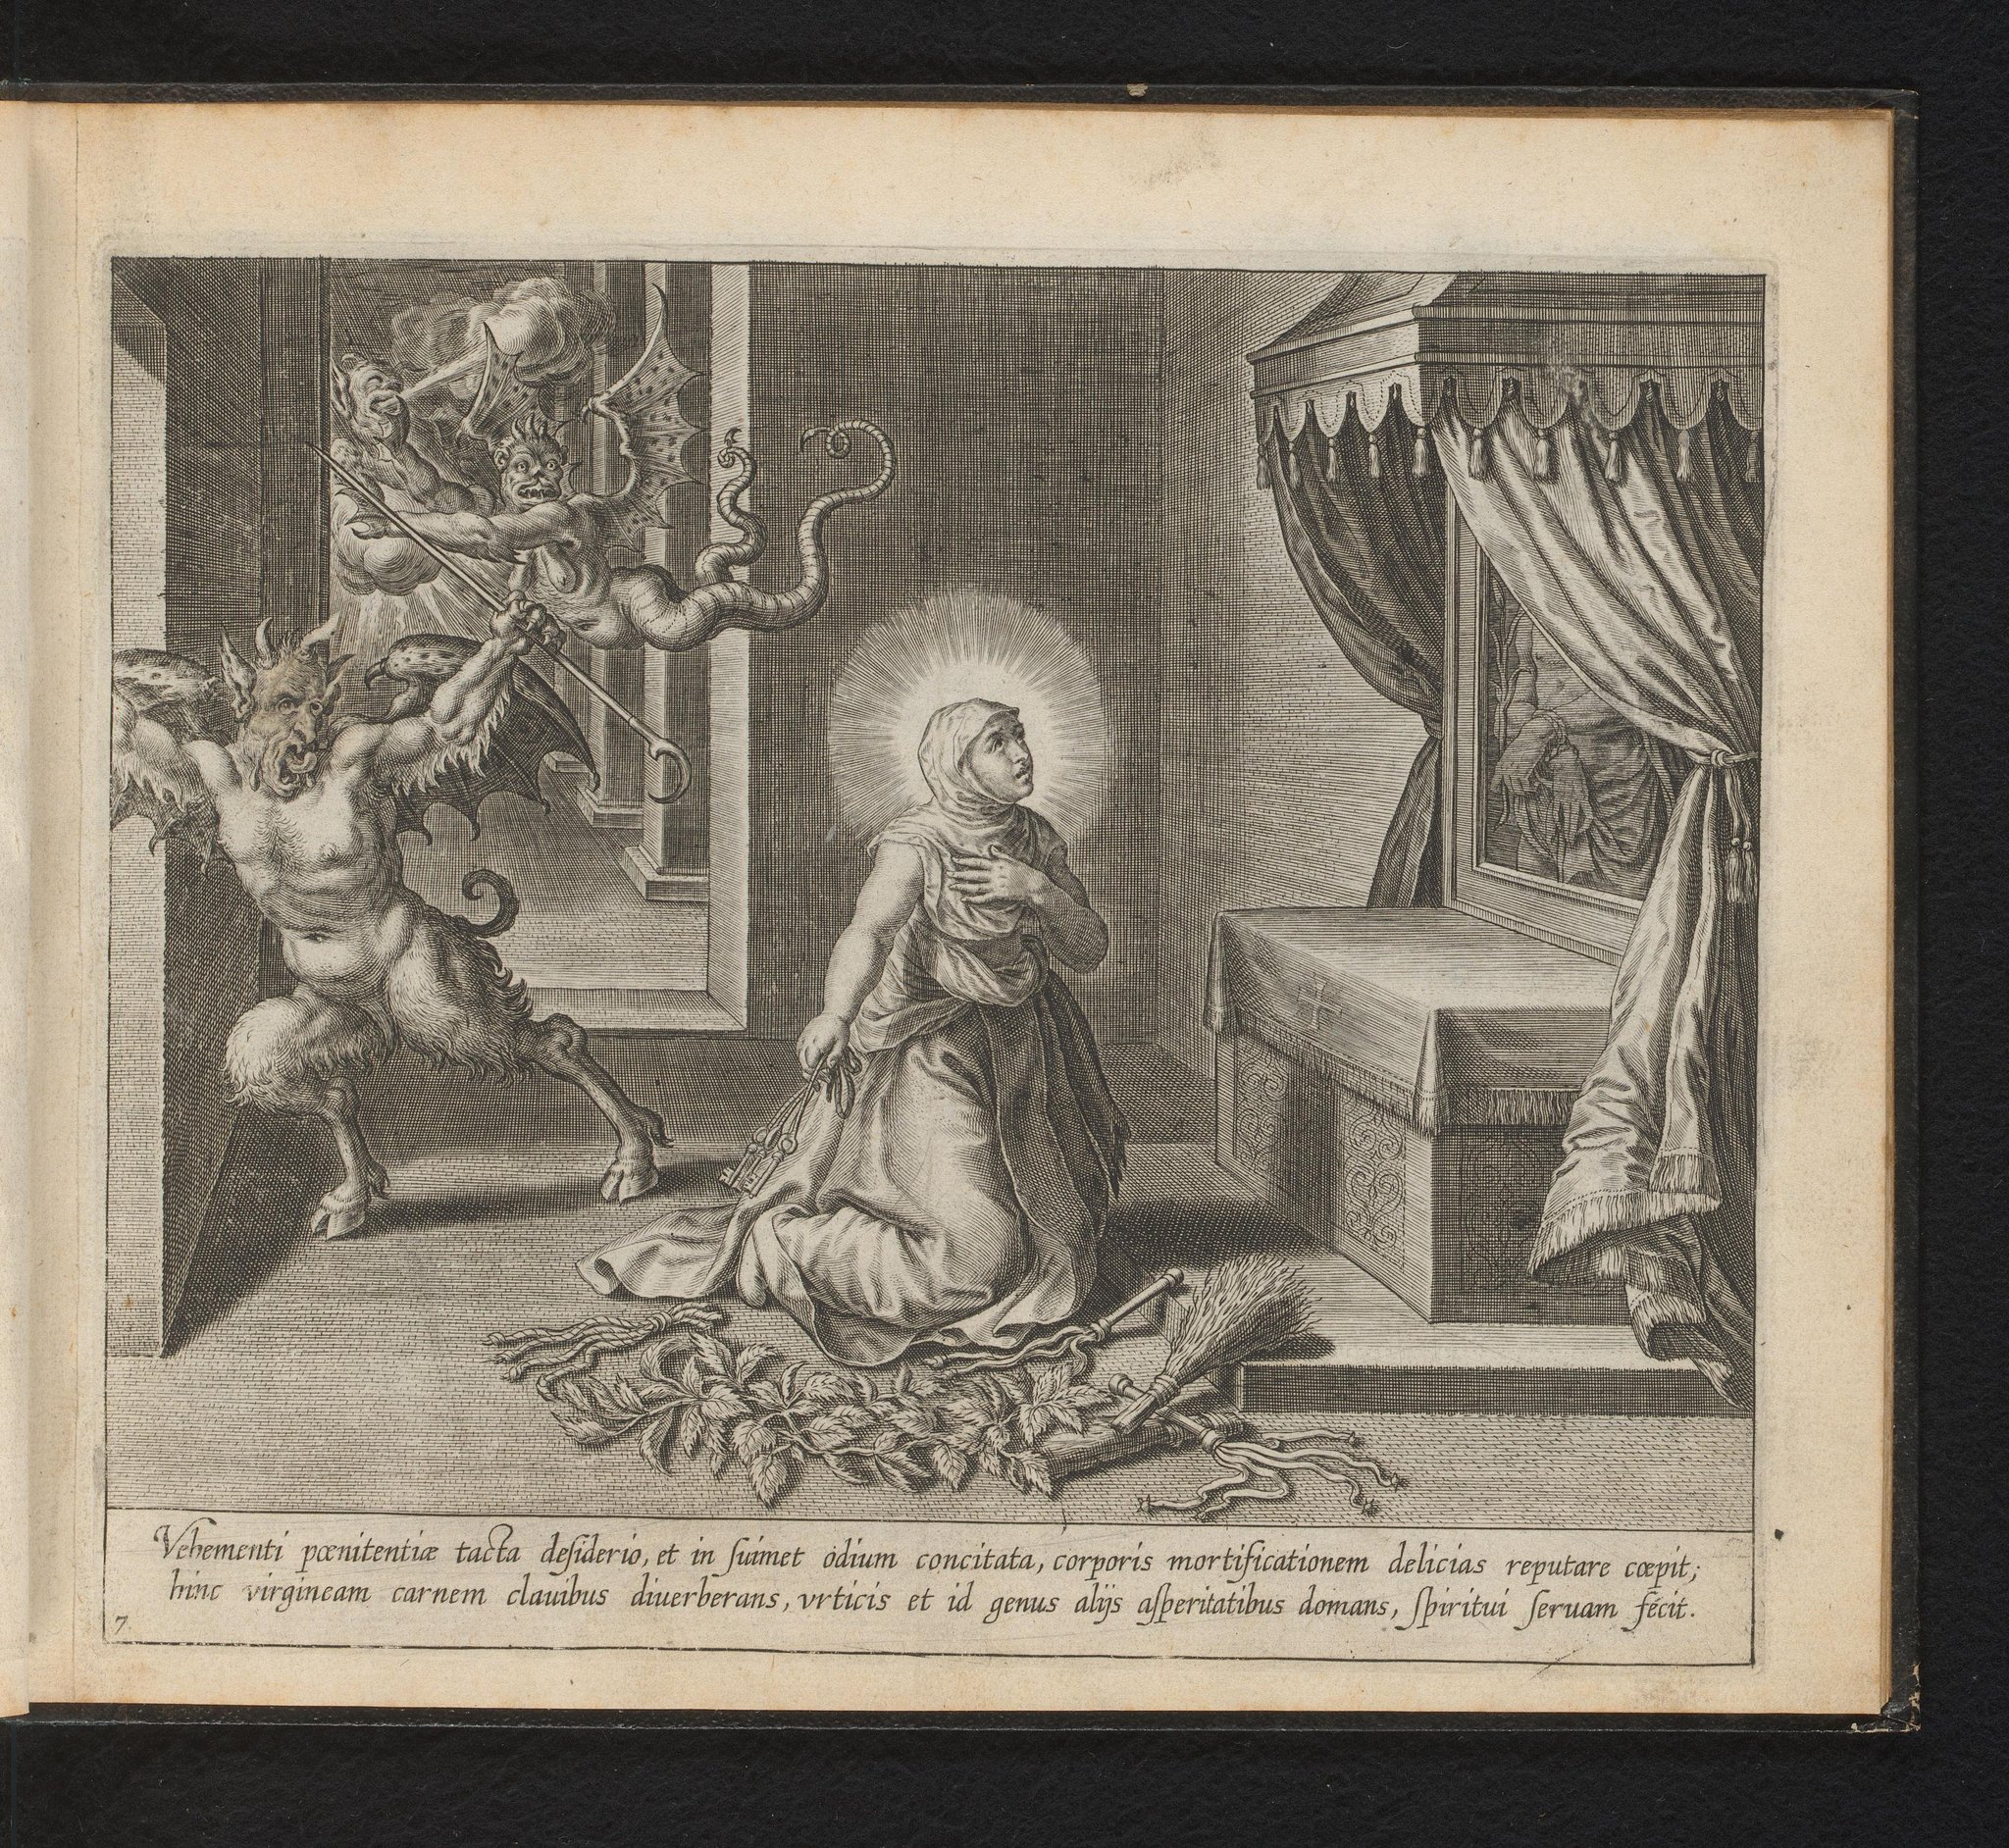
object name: print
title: Theresa doet boete door zelfkastijding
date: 1613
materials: paper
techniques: engraving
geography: antwerp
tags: the (nude) human figure; 'corpo humano' (ripa) (+ chastising), the foundress of the reformed (discalced) carmelites, t(h)eres(i)a of avila; possible attributes: angel, arrow, dove, heart (flaming or pierced by an arrow), devil(s) appearing to mortals, trying to seduce them; temptation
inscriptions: caption: ‘Vehementi poenitentiae tacta...spiritui servam fecit.’, number: ‘7’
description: Prent in album 'Vita B. Virginis Teresiae A. Jesu ordinis carmelitarum excalceatorum piae restauratricis..., 1613.